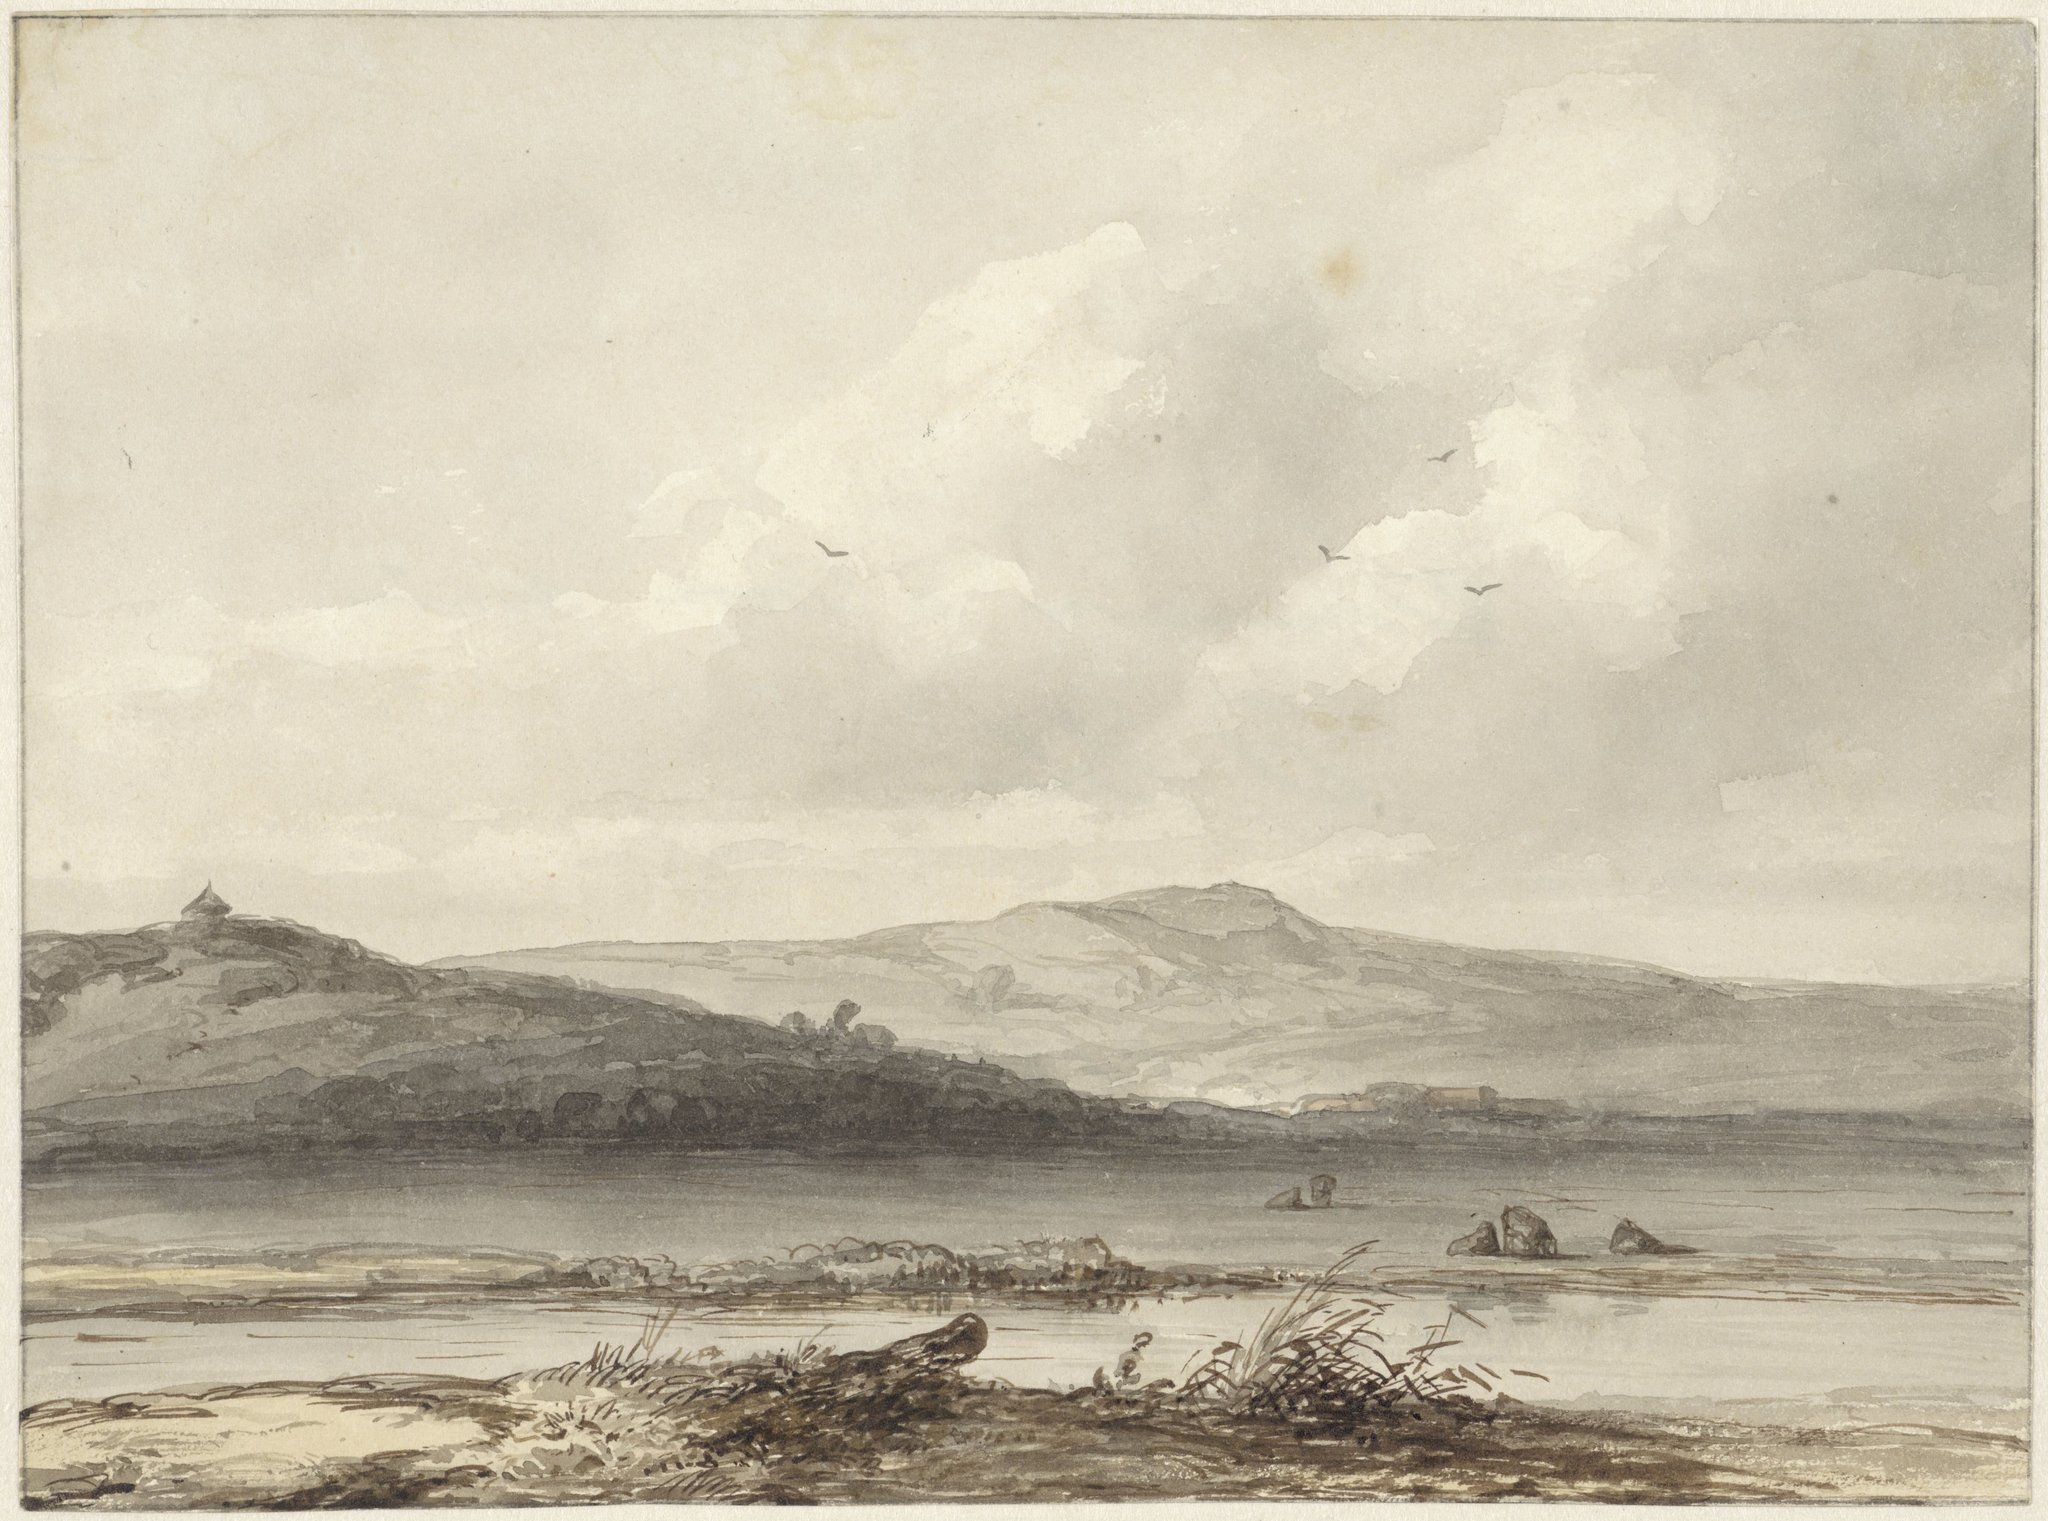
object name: drawing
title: Duinlandschap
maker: johannes franciscus hoppenbrouwers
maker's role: draughtsman, painter, print maker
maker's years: 1819-1866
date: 1844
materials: ink, paper, pencil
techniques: brush, pen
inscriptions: signature and date: ‘J.F. Hoppenbrouwers. 44’, annotation: ‘Souvenir a mon ami/D.Bles/...’